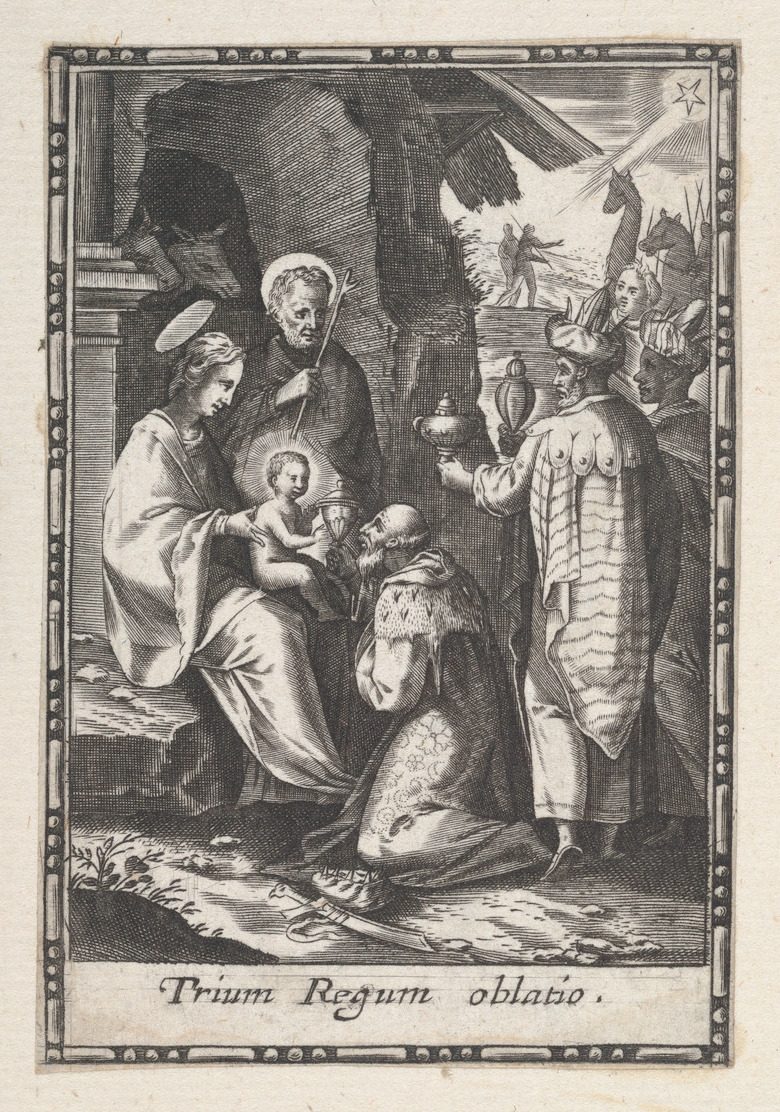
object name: print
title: Adoration of the Magi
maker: Anonymous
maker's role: artist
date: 1590-1620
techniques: engraving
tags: adoration of the magi